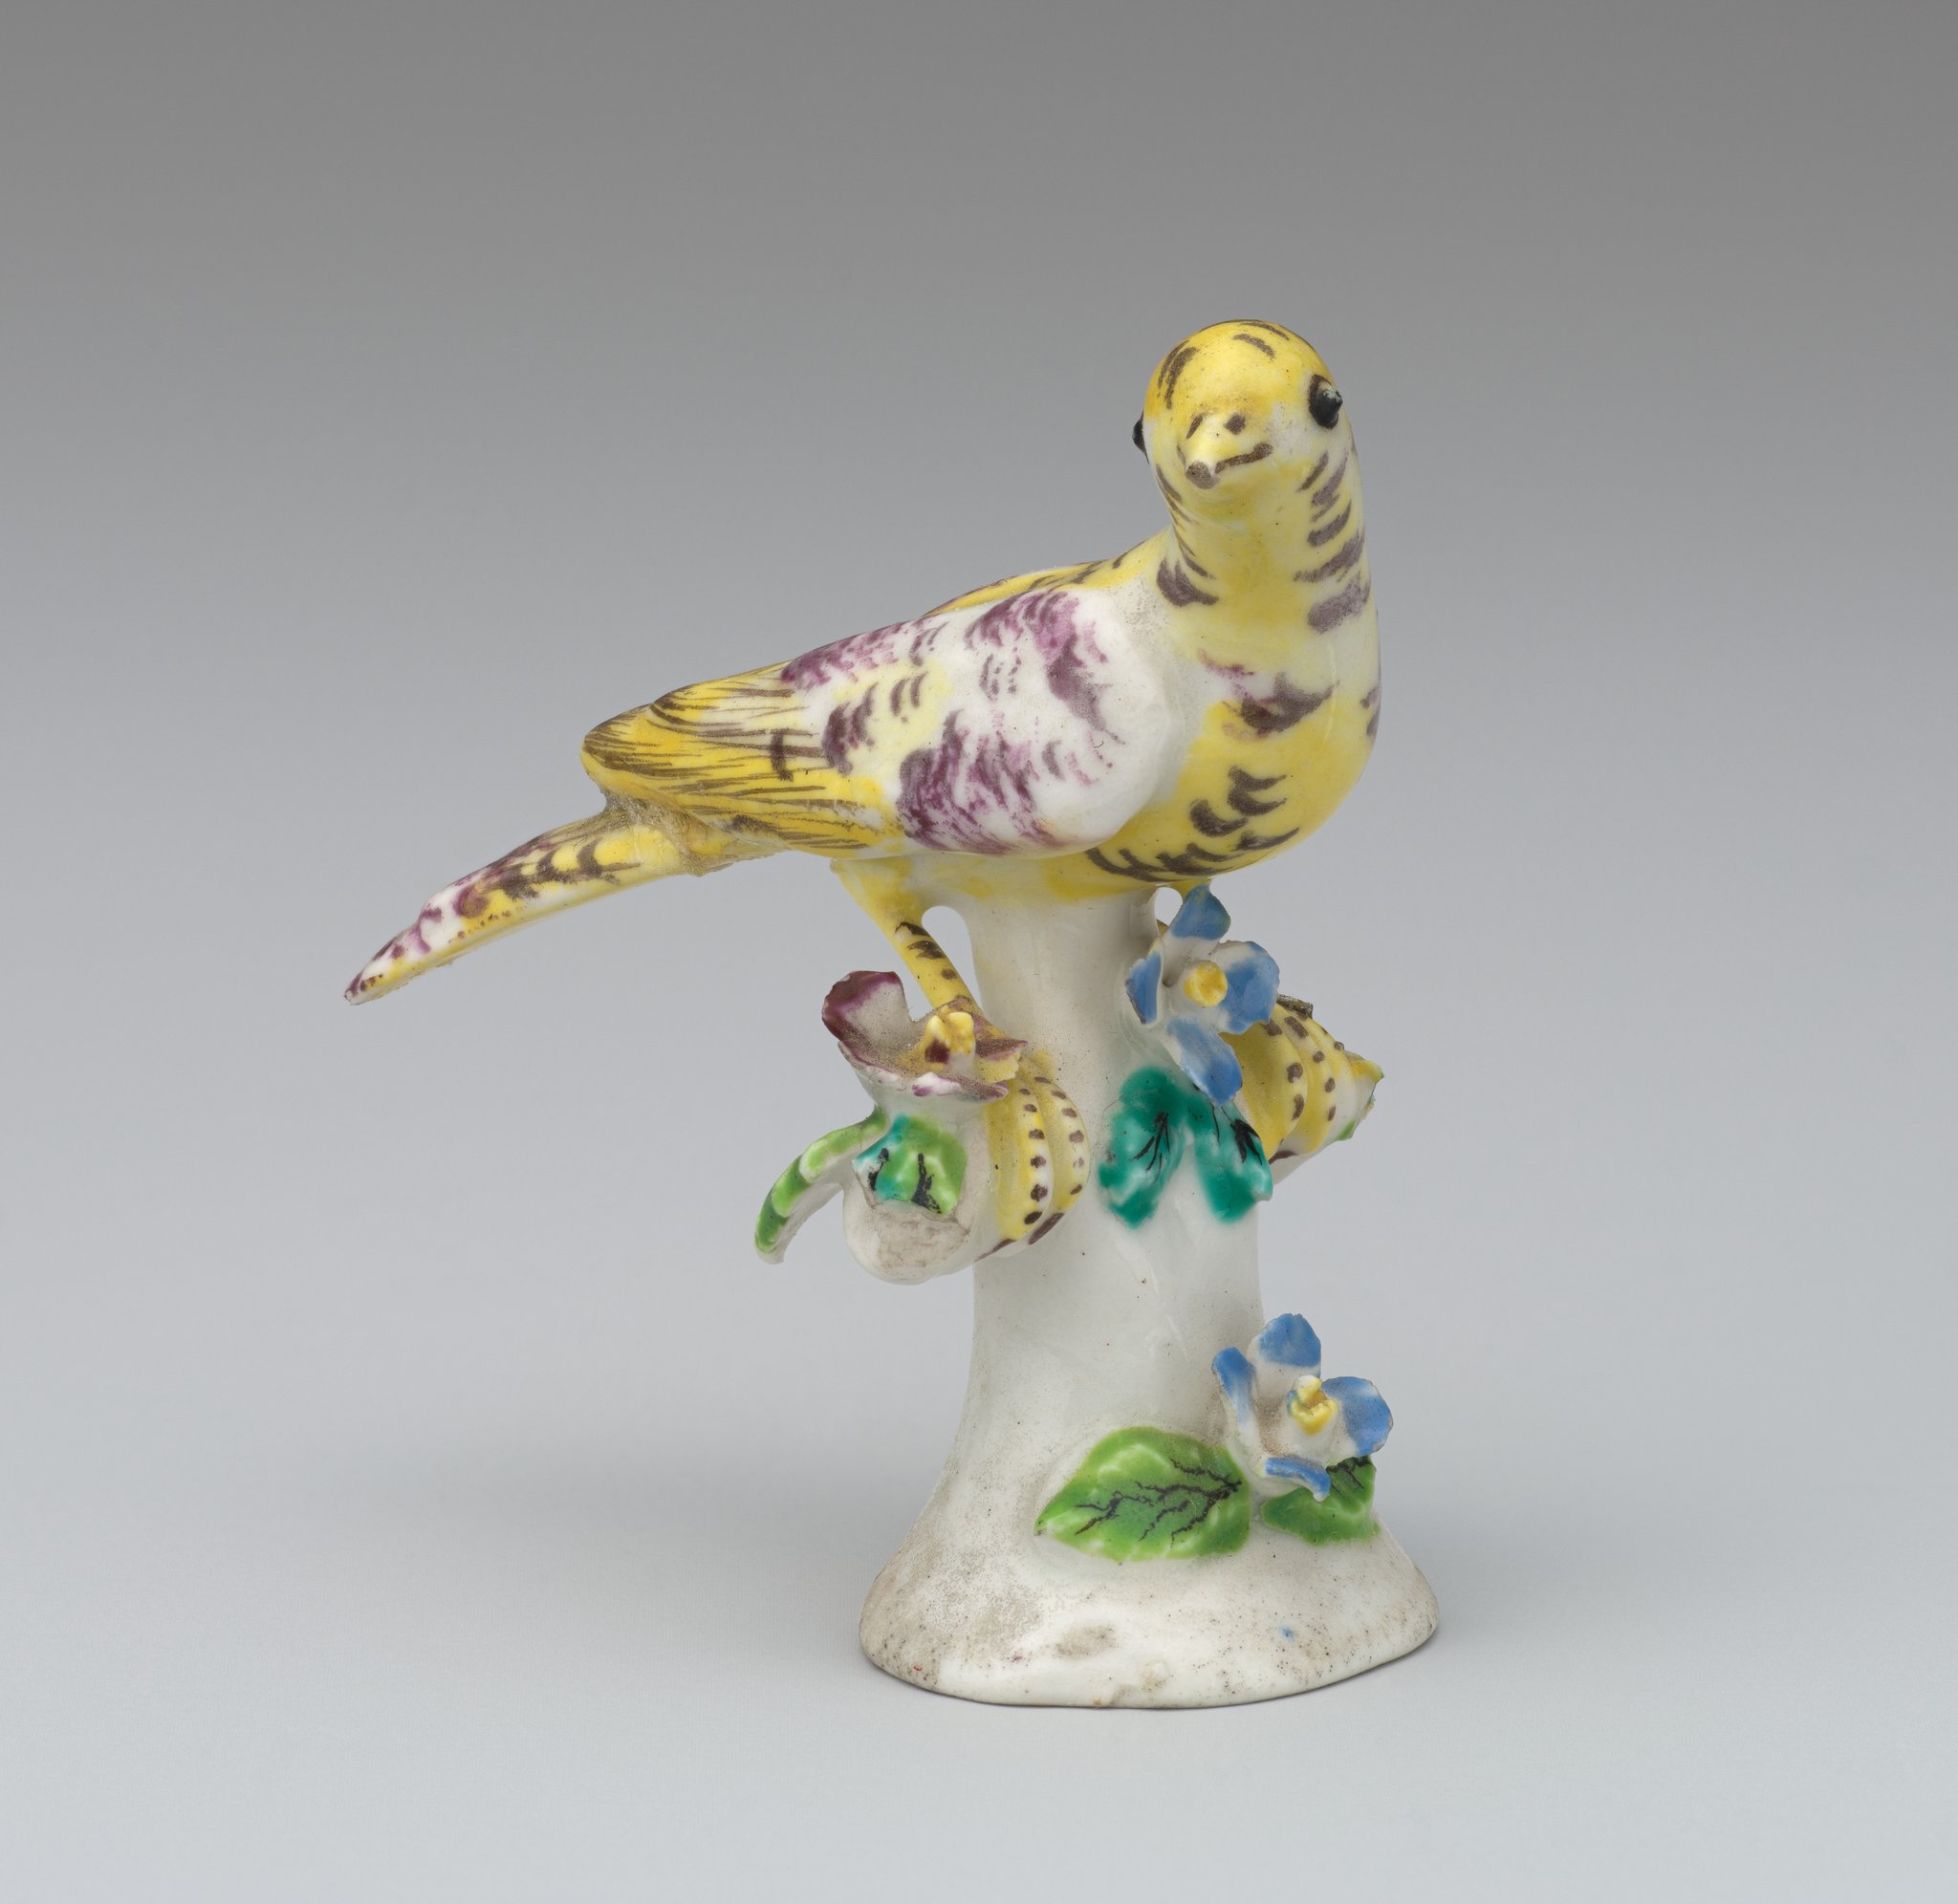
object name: figure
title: Bunting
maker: bow porcelain factory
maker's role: factory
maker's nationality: british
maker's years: 1747-1776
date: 1760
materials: soft paste porcelain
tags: birds